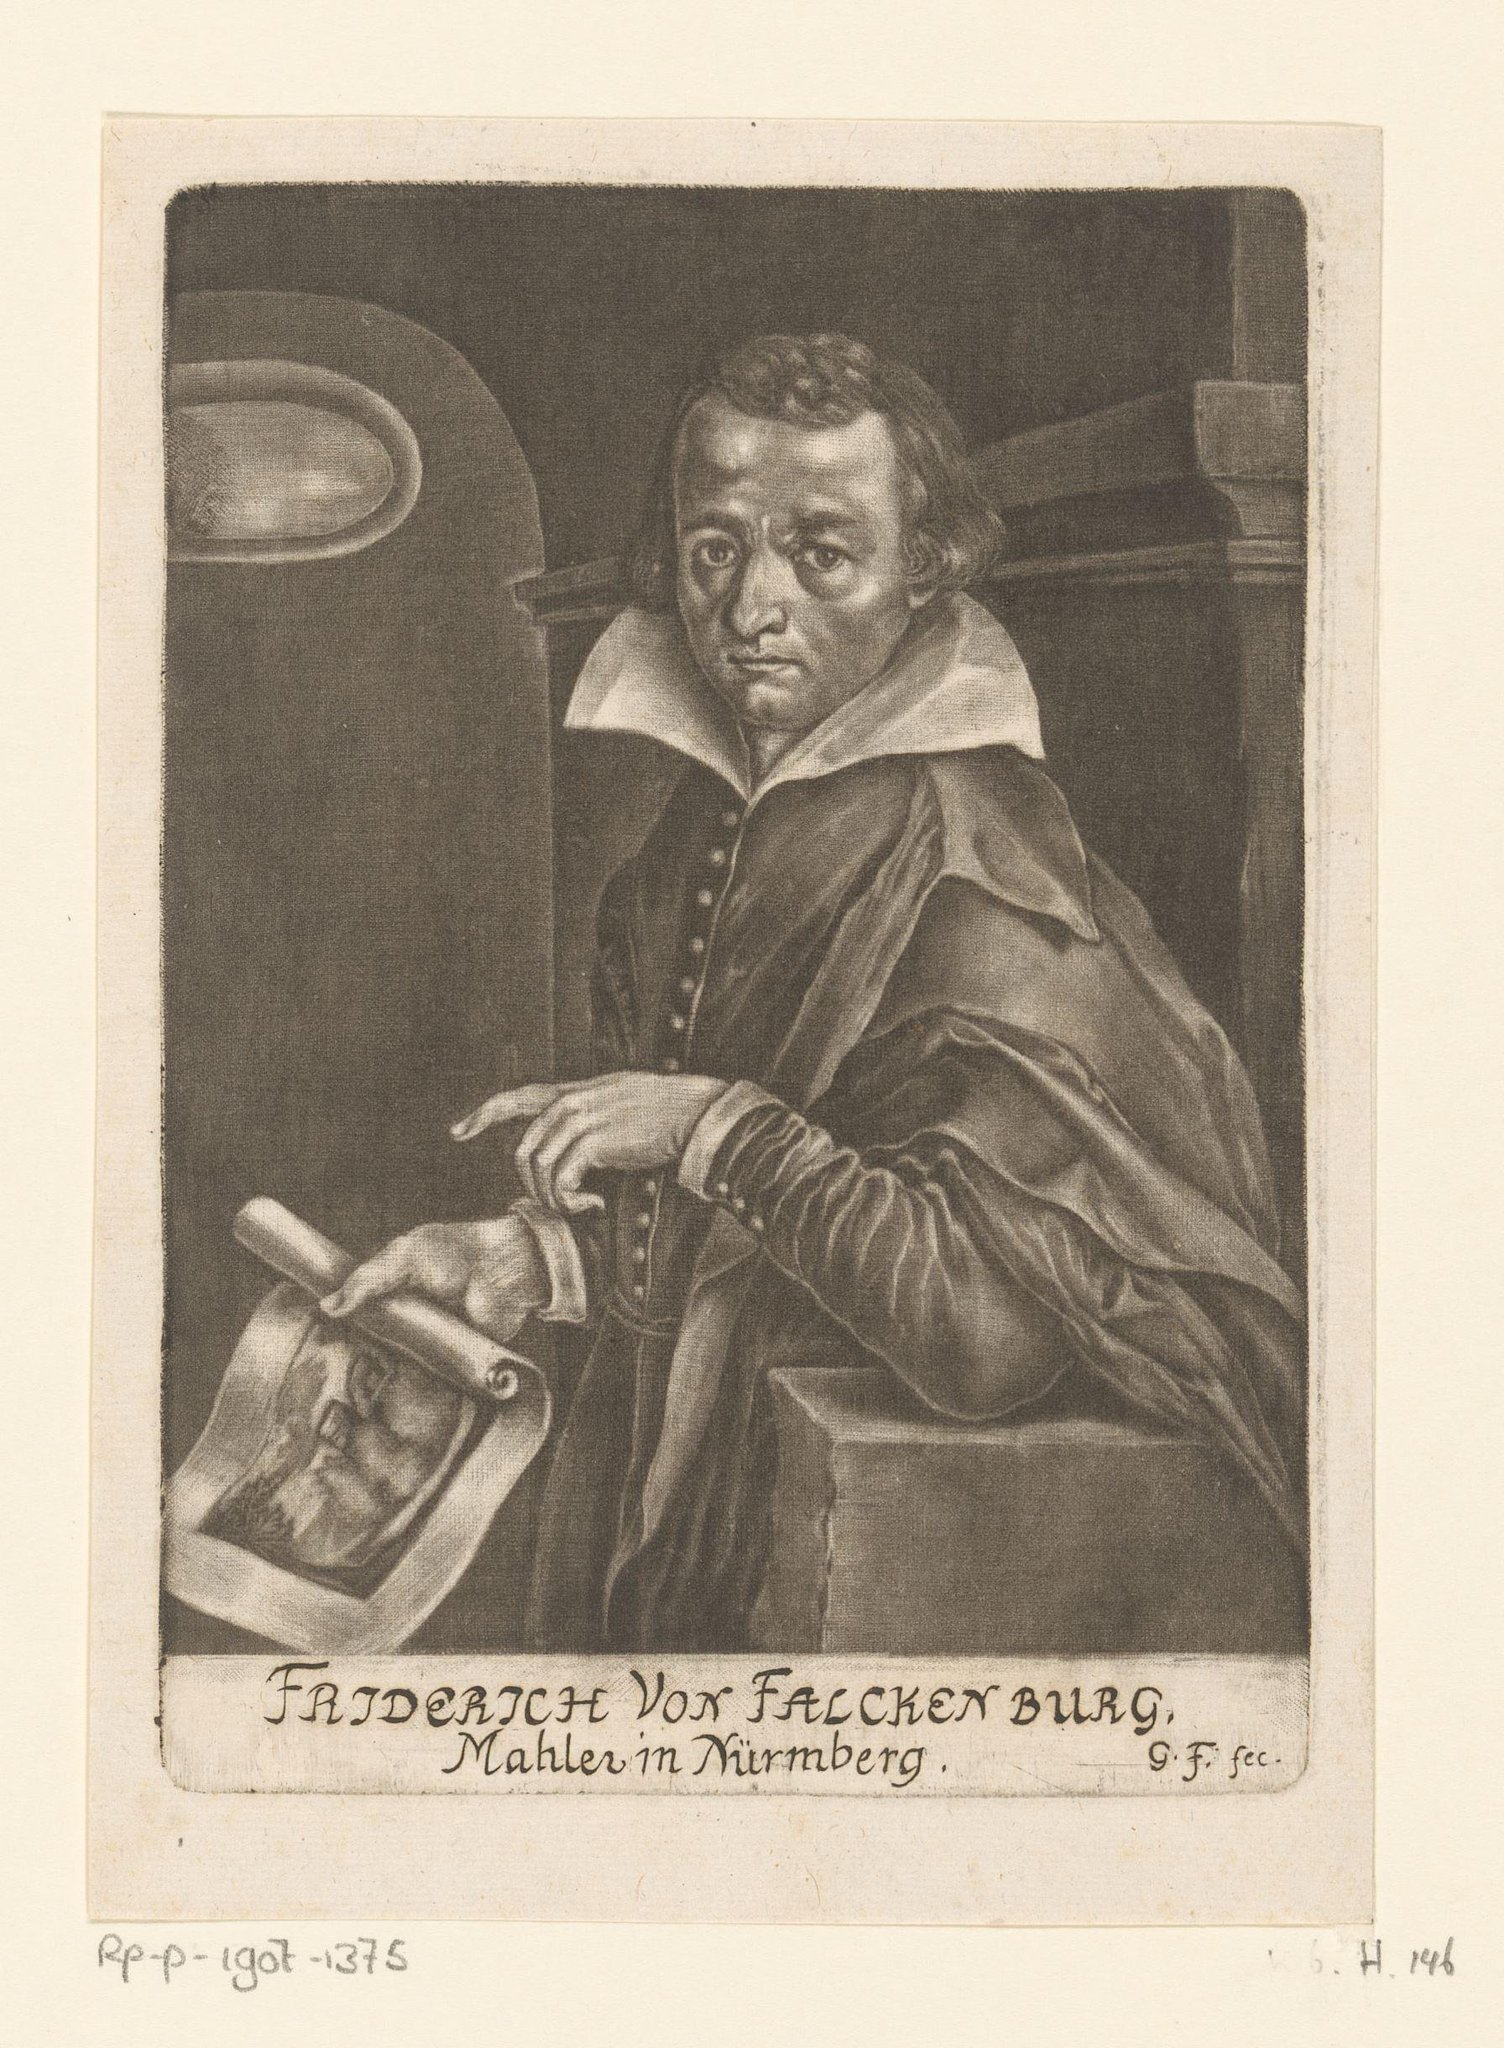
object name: print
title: Portret van Frederik I. van Valckenborch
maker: georg fennitzer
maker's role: print maker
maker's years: 1646-1722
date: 1656-1722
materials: paper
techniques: mezzotint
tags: antwerp, painter, historical persons, portrait, self-portrait of painter, painting (including book-illumination, miniature-painting)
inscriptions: collector's mark: Lugt 2228